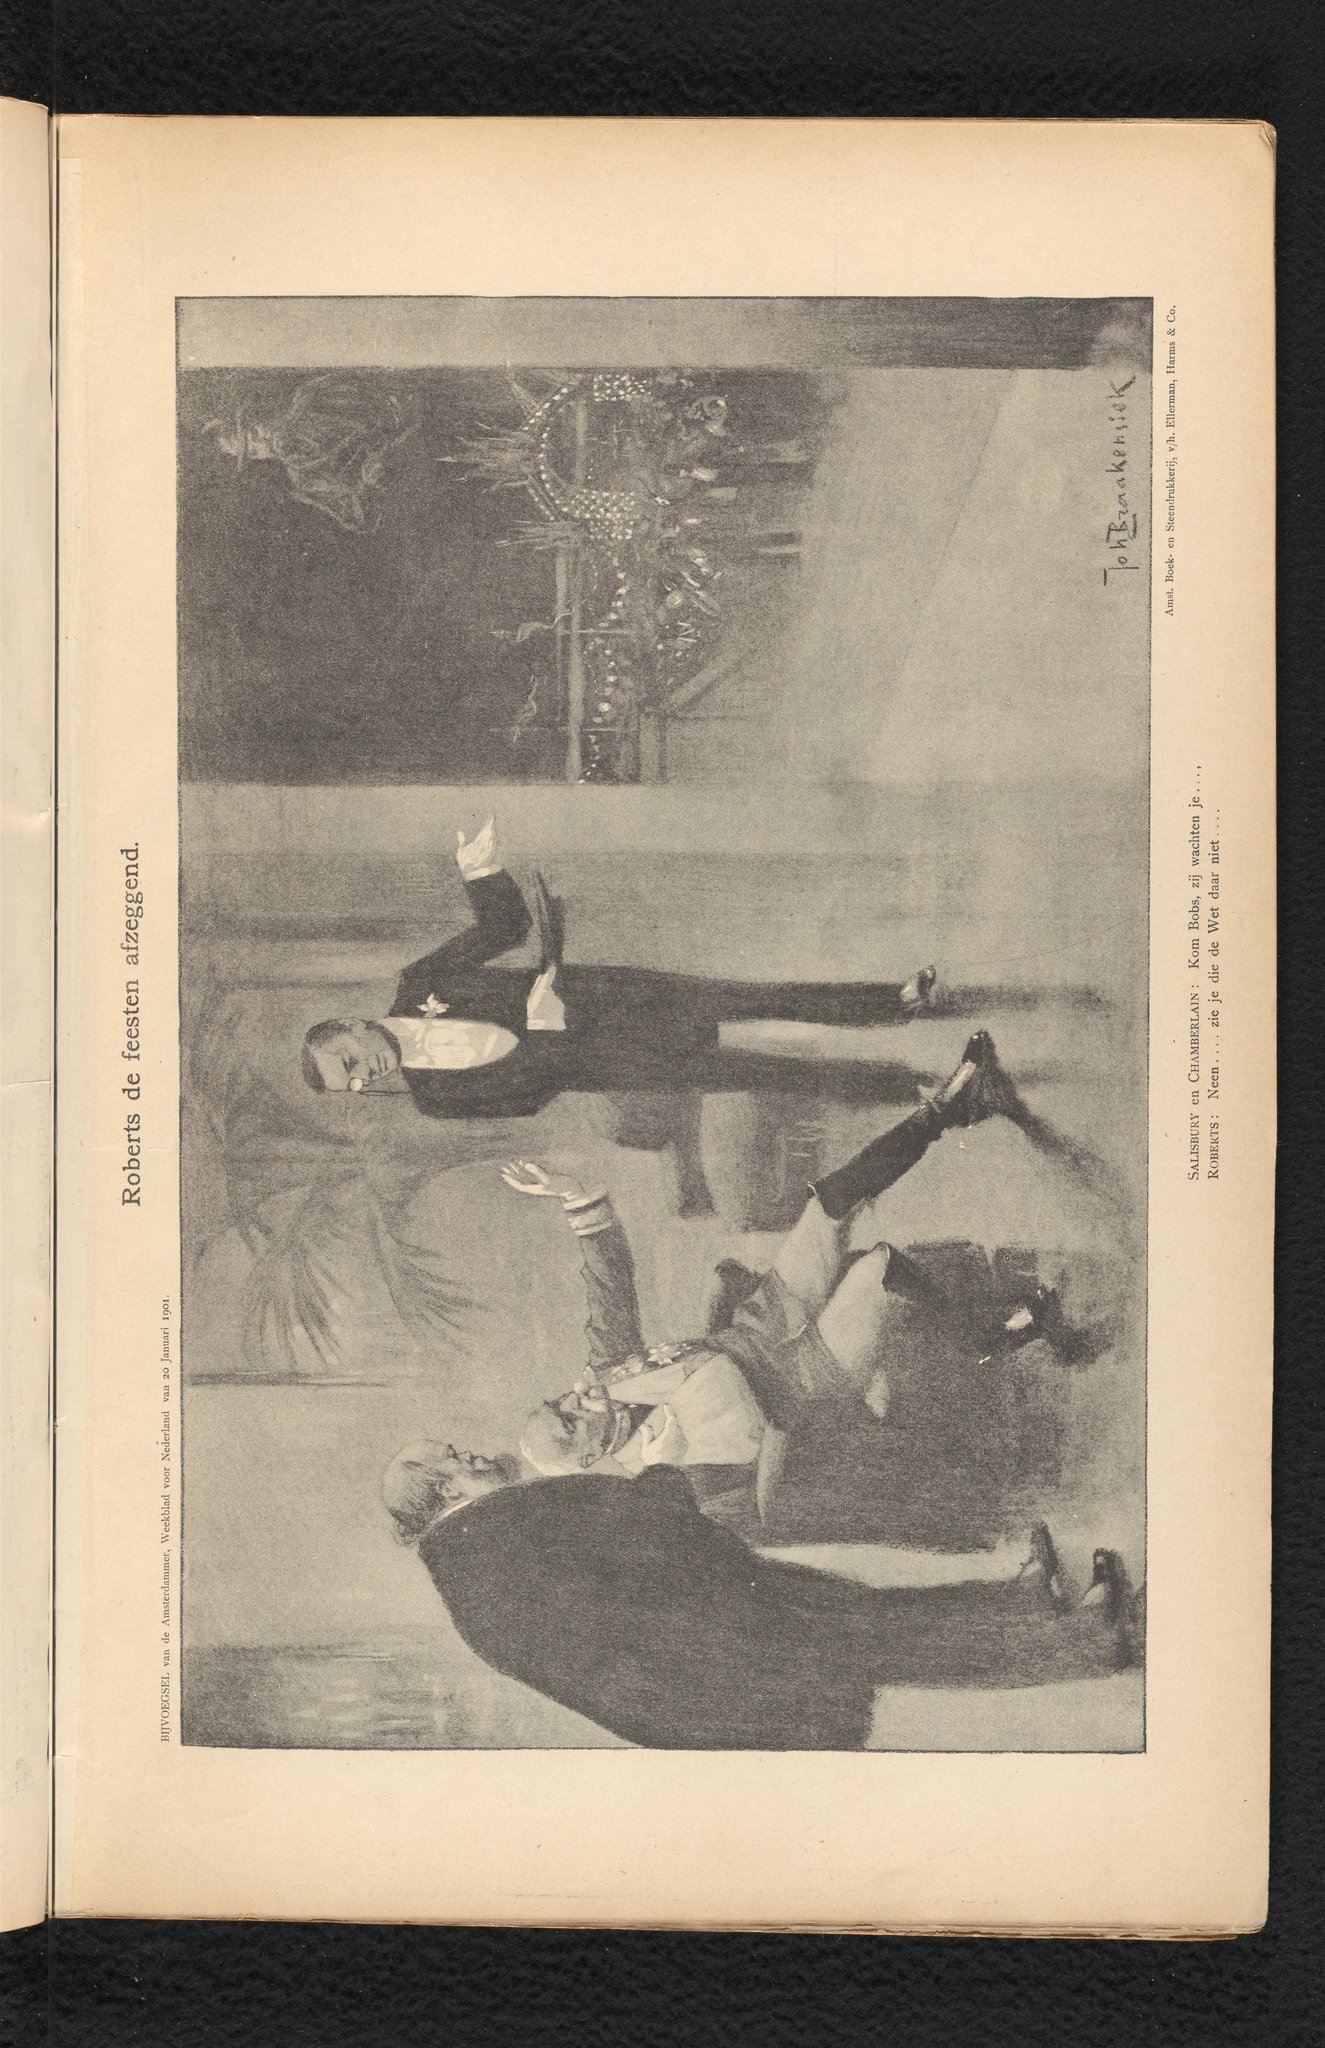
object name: photomechanical print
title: Roberts de feesten afzeggend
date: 1901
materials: paper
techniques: autotype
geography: netherlands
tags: politician, fear, dread; 'paura', 'timidità o timore', 'timore' (ripa), spirit, ghost, political caricatures and satires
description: Joseph Chamberlain en Lord Salisbury proberen de Britse generaal Roberts over te halen naar een feest te gaan, maar Roberts is bang voor de schim van Christiaan de Wet die hij boven het feest ziet hangen.